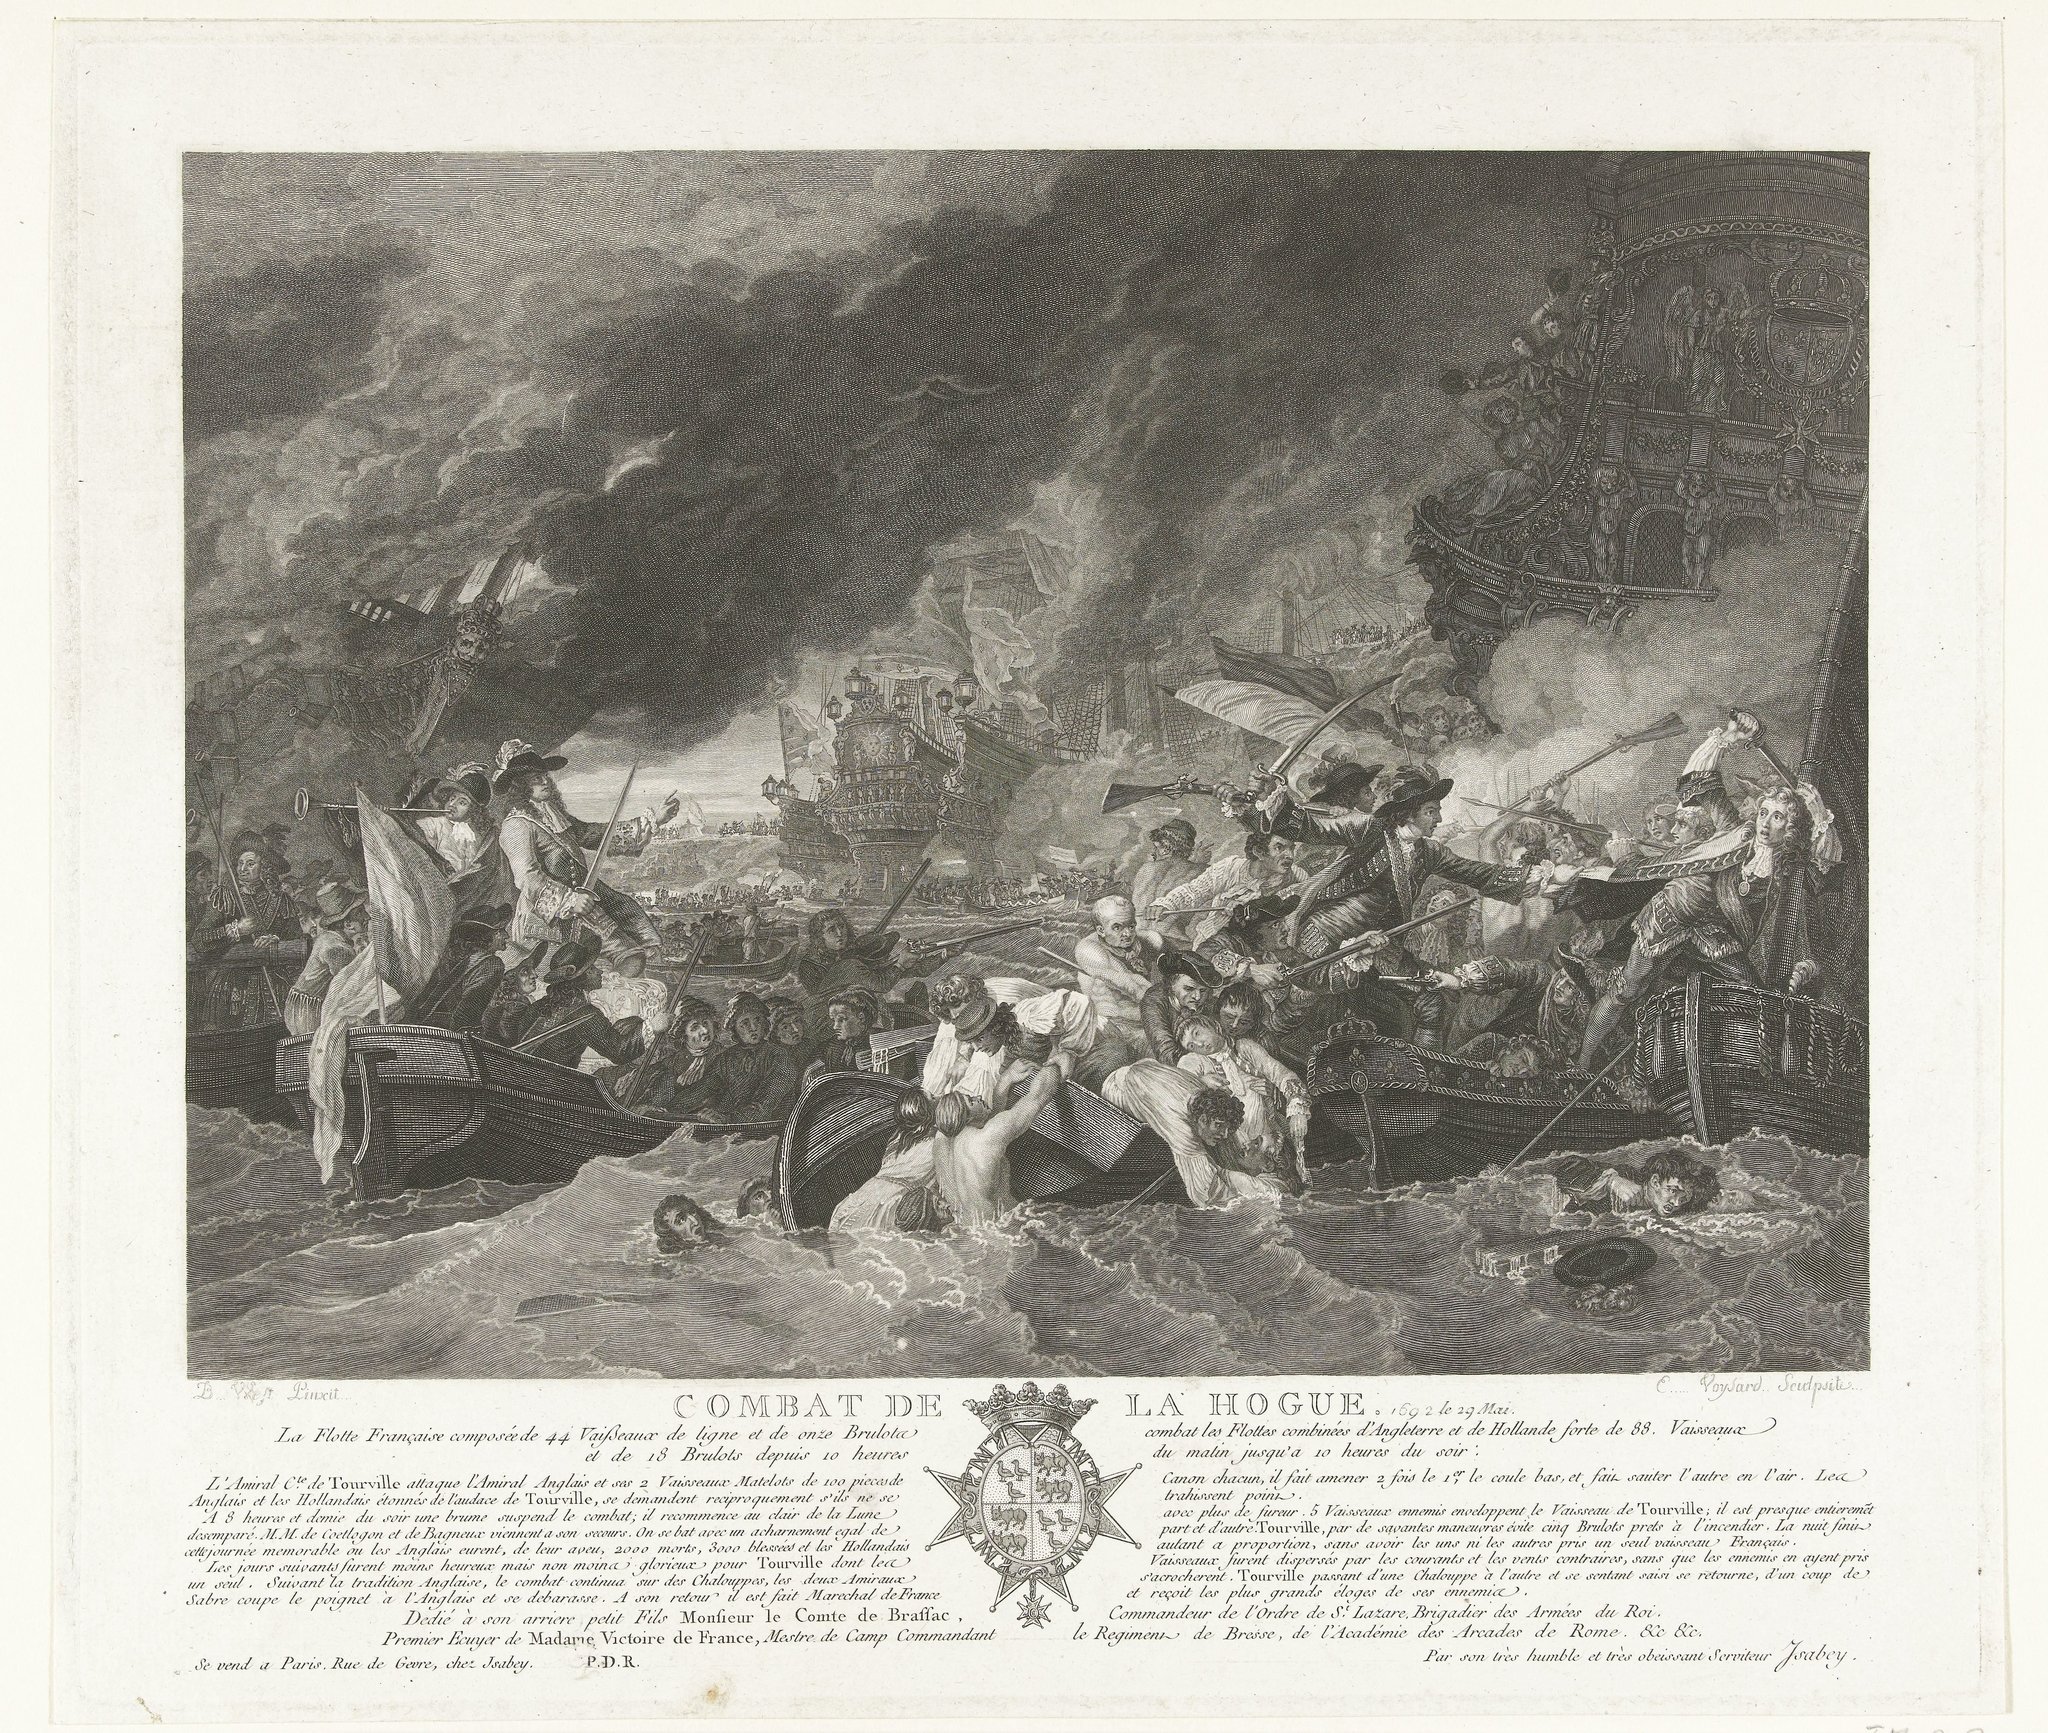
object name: print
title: Combat de La Hogue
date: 1780-1812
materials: paper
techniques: etching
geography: france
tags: paris, battle (+ naval force)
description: Zeeslag bij Kaap la Hogue waarbij de Fransen onder admiraal de Tourville werden verslagen door de gecombineerde vloot van Engeland en Holland onder de admiralen Russel en Almonde, 29 mei t/m 3 juni 1692. Afgebeeld is het moment dat Tourville van een boot in een andere wil stappen en vastgegrepen wordt door een Engelsman wiens hand hij met zijn zwaard zal afhouwen. Rechts en centraal Franse schepen. In het onderschrift de titel en een beschrijving in het Frans.